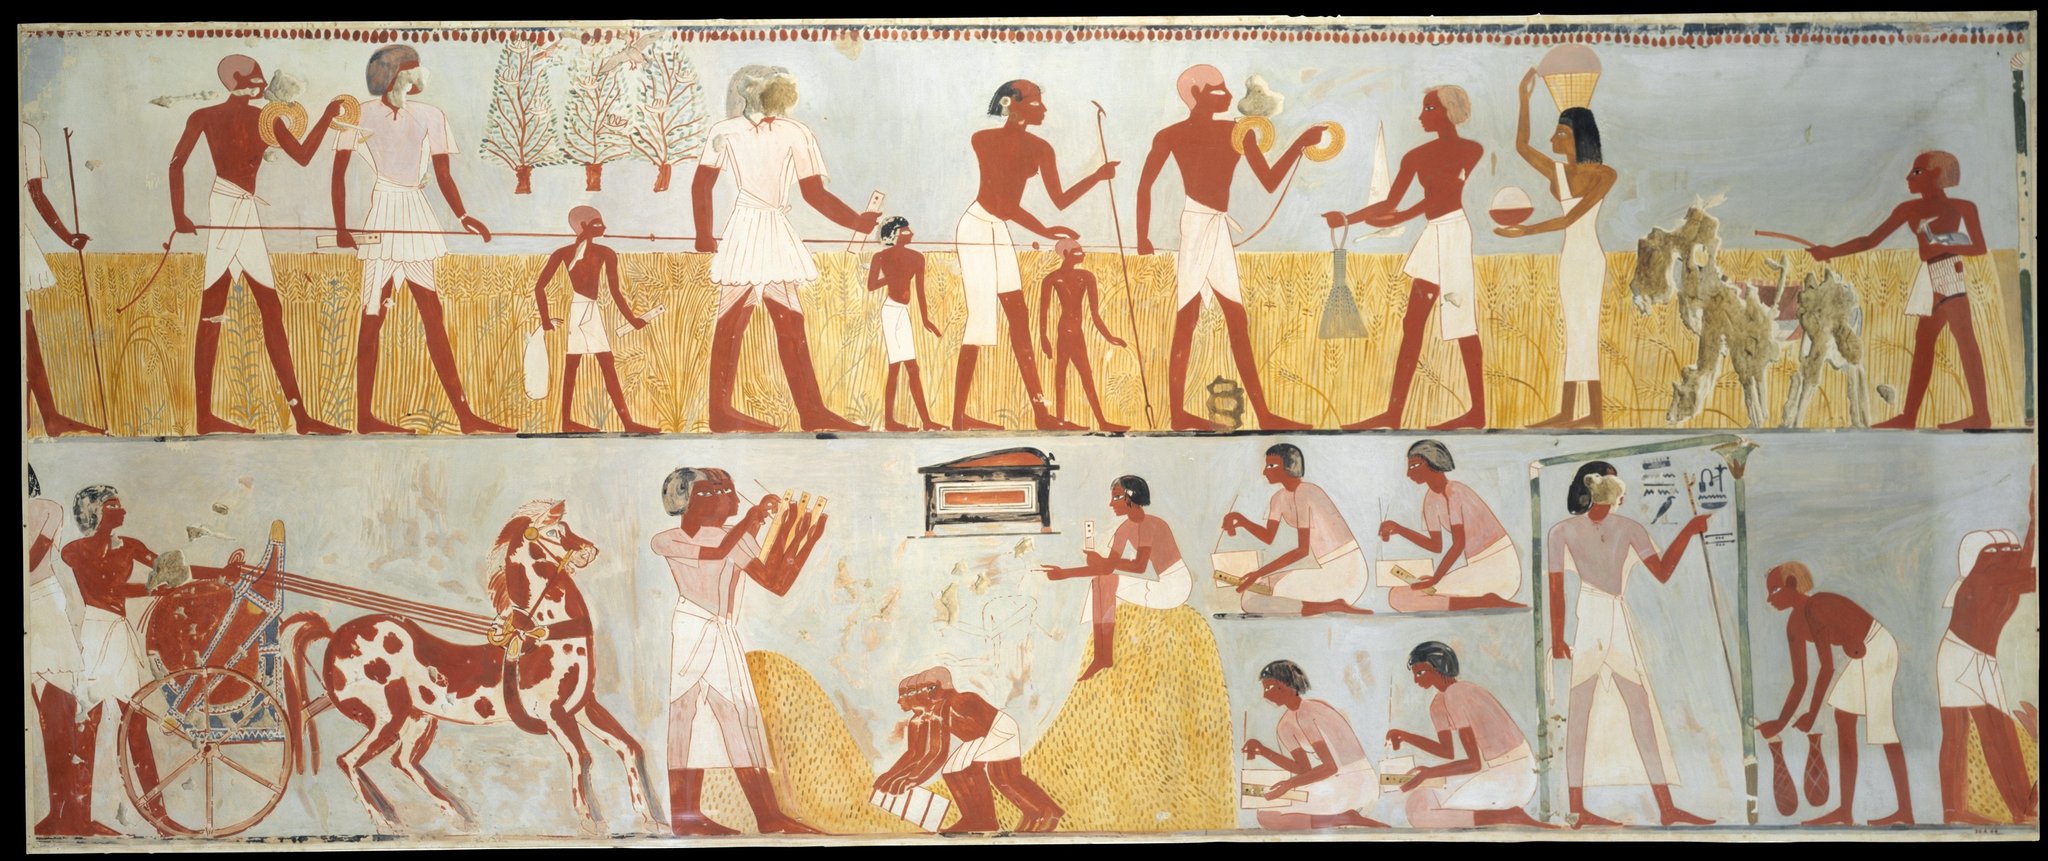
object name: facsimile, menna tt 69, harvest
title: Harvest Scenes, Tomb of Menna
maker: charles k. wilkinson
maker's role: artist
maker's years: 1897-1986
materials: paper, paint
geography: egypt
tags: men,horses,working,chariots